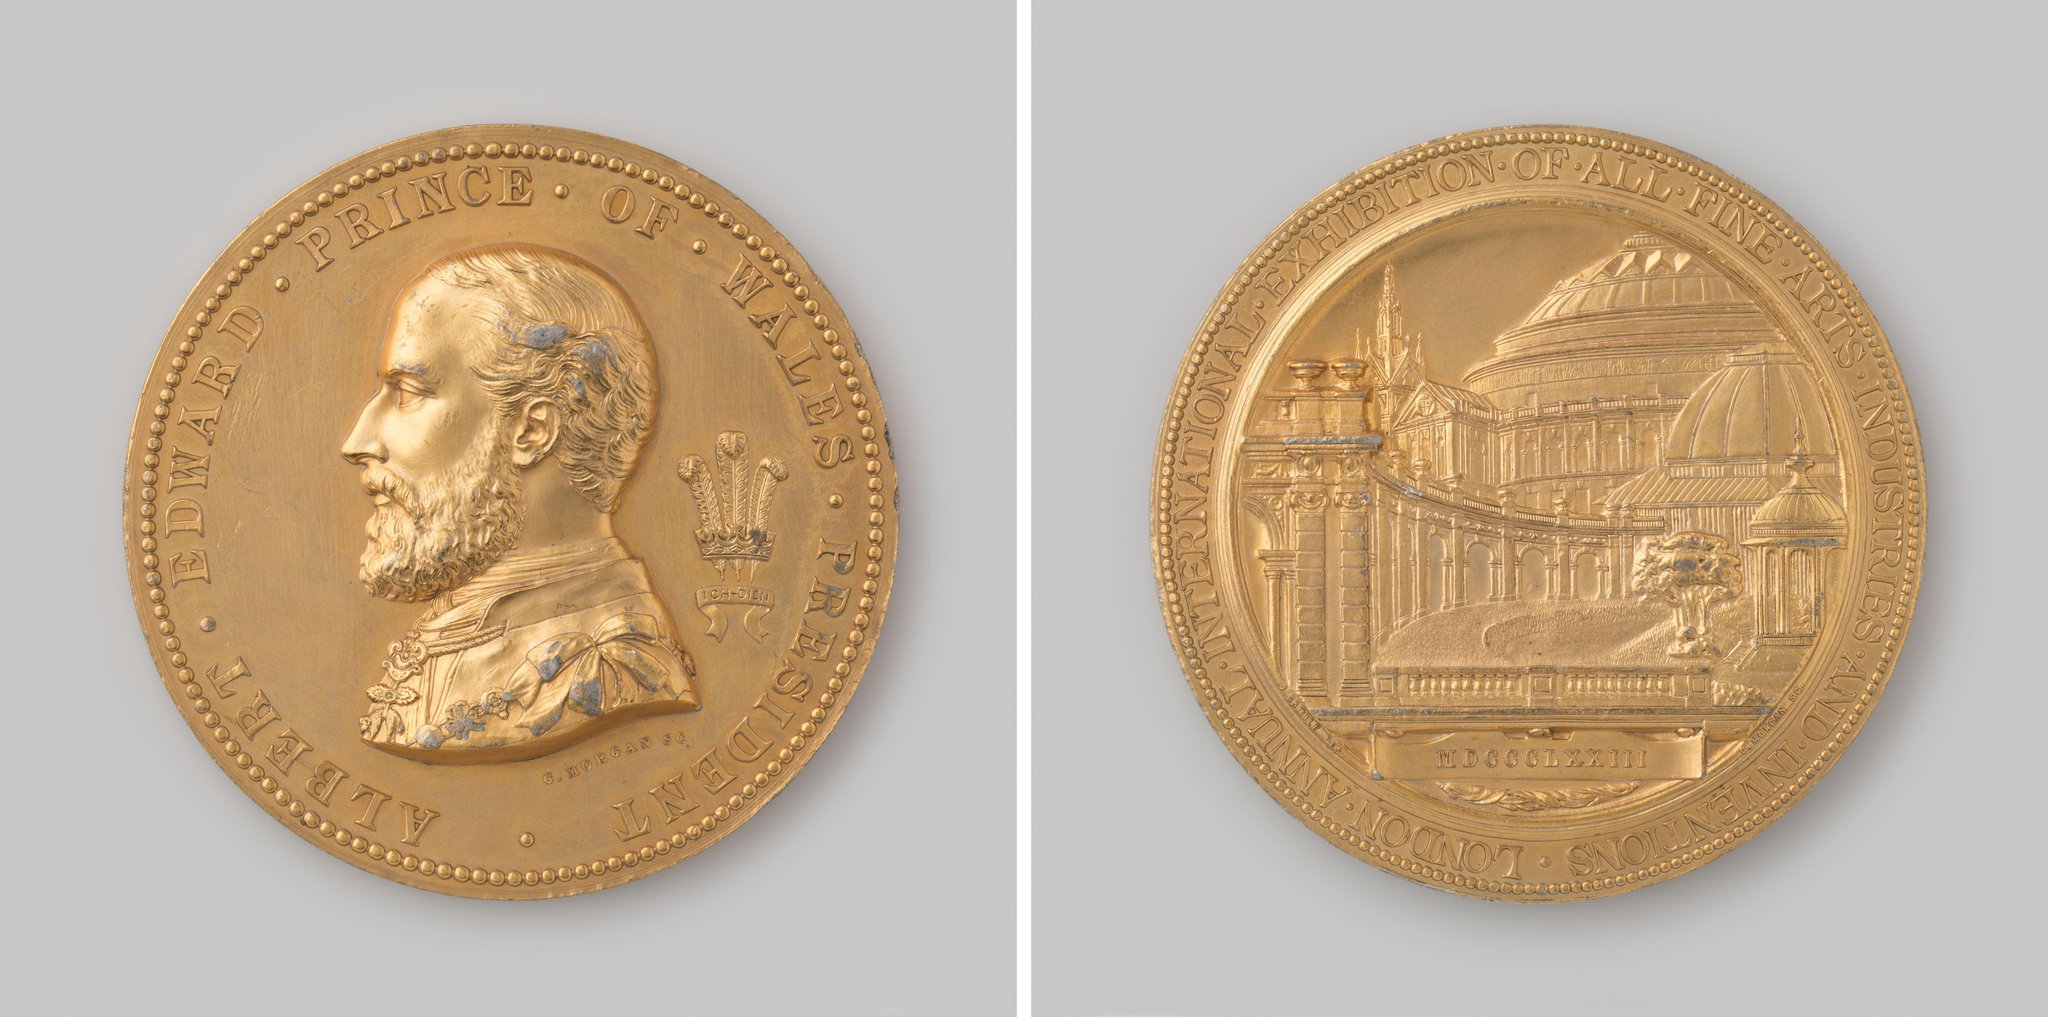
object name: history medal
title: Jaarlijkse Expositie van Schone Kunsten, Industrie en Uitvindingen te Londen 1873 uitgereikt aan W.C. Nakken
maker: g. morgan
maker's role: die cutter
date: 1873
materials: silver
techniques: striking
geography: london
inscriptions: inscription: ‘W.C. NAKKEN CATALOGUE N° 220 ETC.’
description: Vergulde penning met randschrift, op de voorzijde het borstbeeld van Albert Prins van Wales naar links met omschrift, op de keerzijde een koepelvormig gebouw met park boven een band met het jaartal, met omschrift, met randinscriptie.